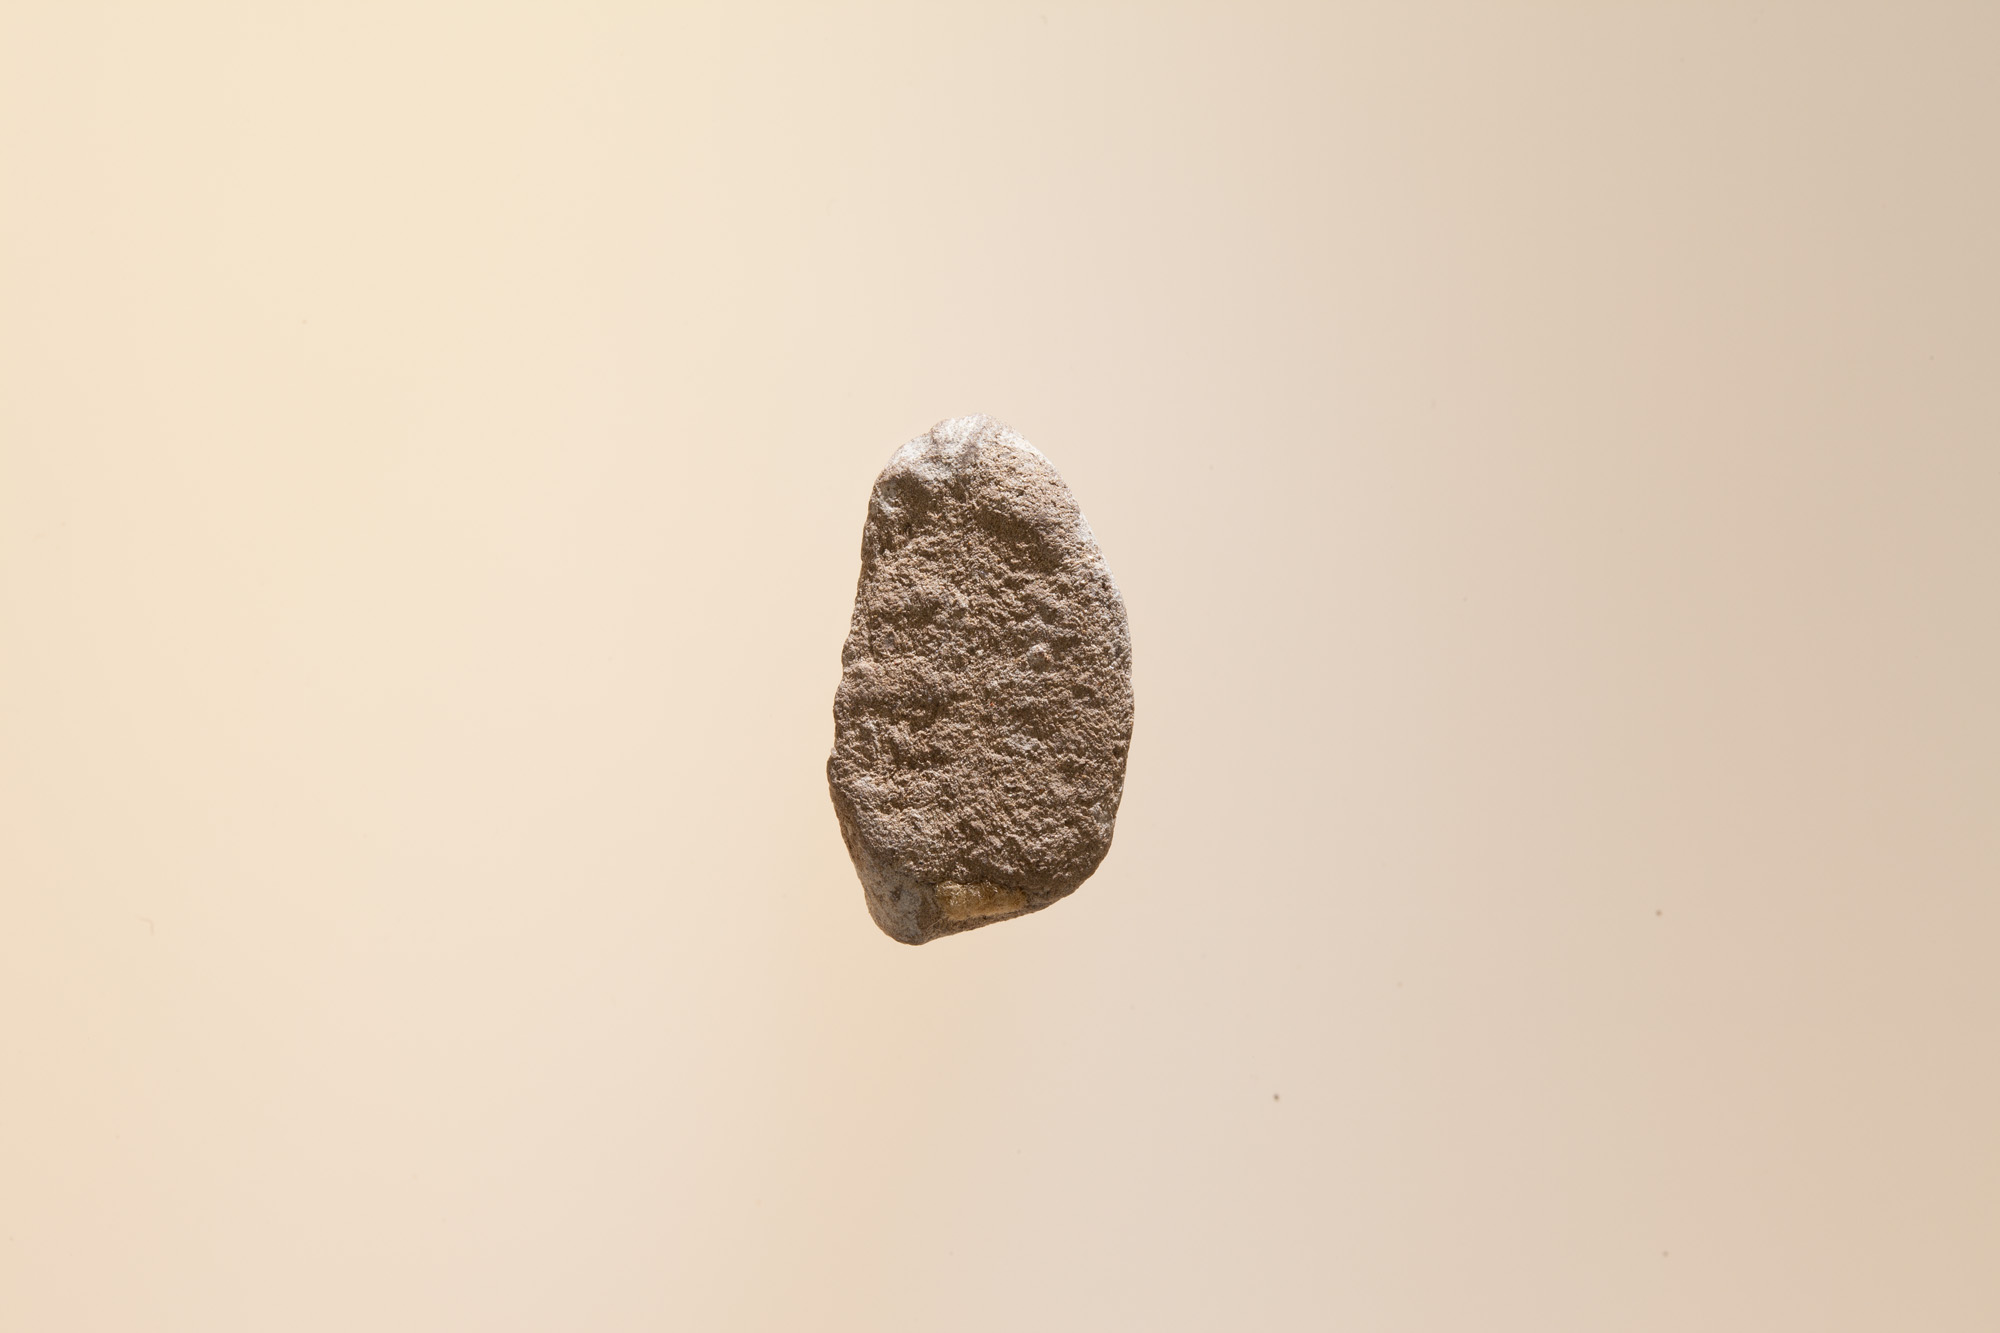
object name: sealing fragment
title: Votive Fragment, Sealing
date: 1479-1458 BCE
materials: clay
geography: egypt